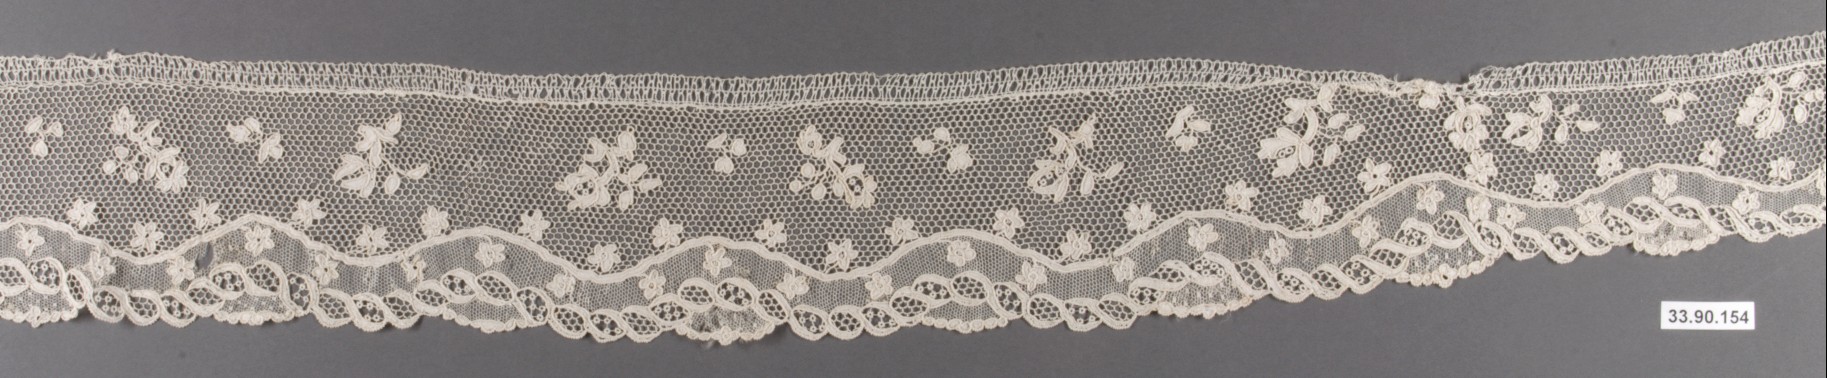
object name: edging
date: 1734-1766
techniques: lace